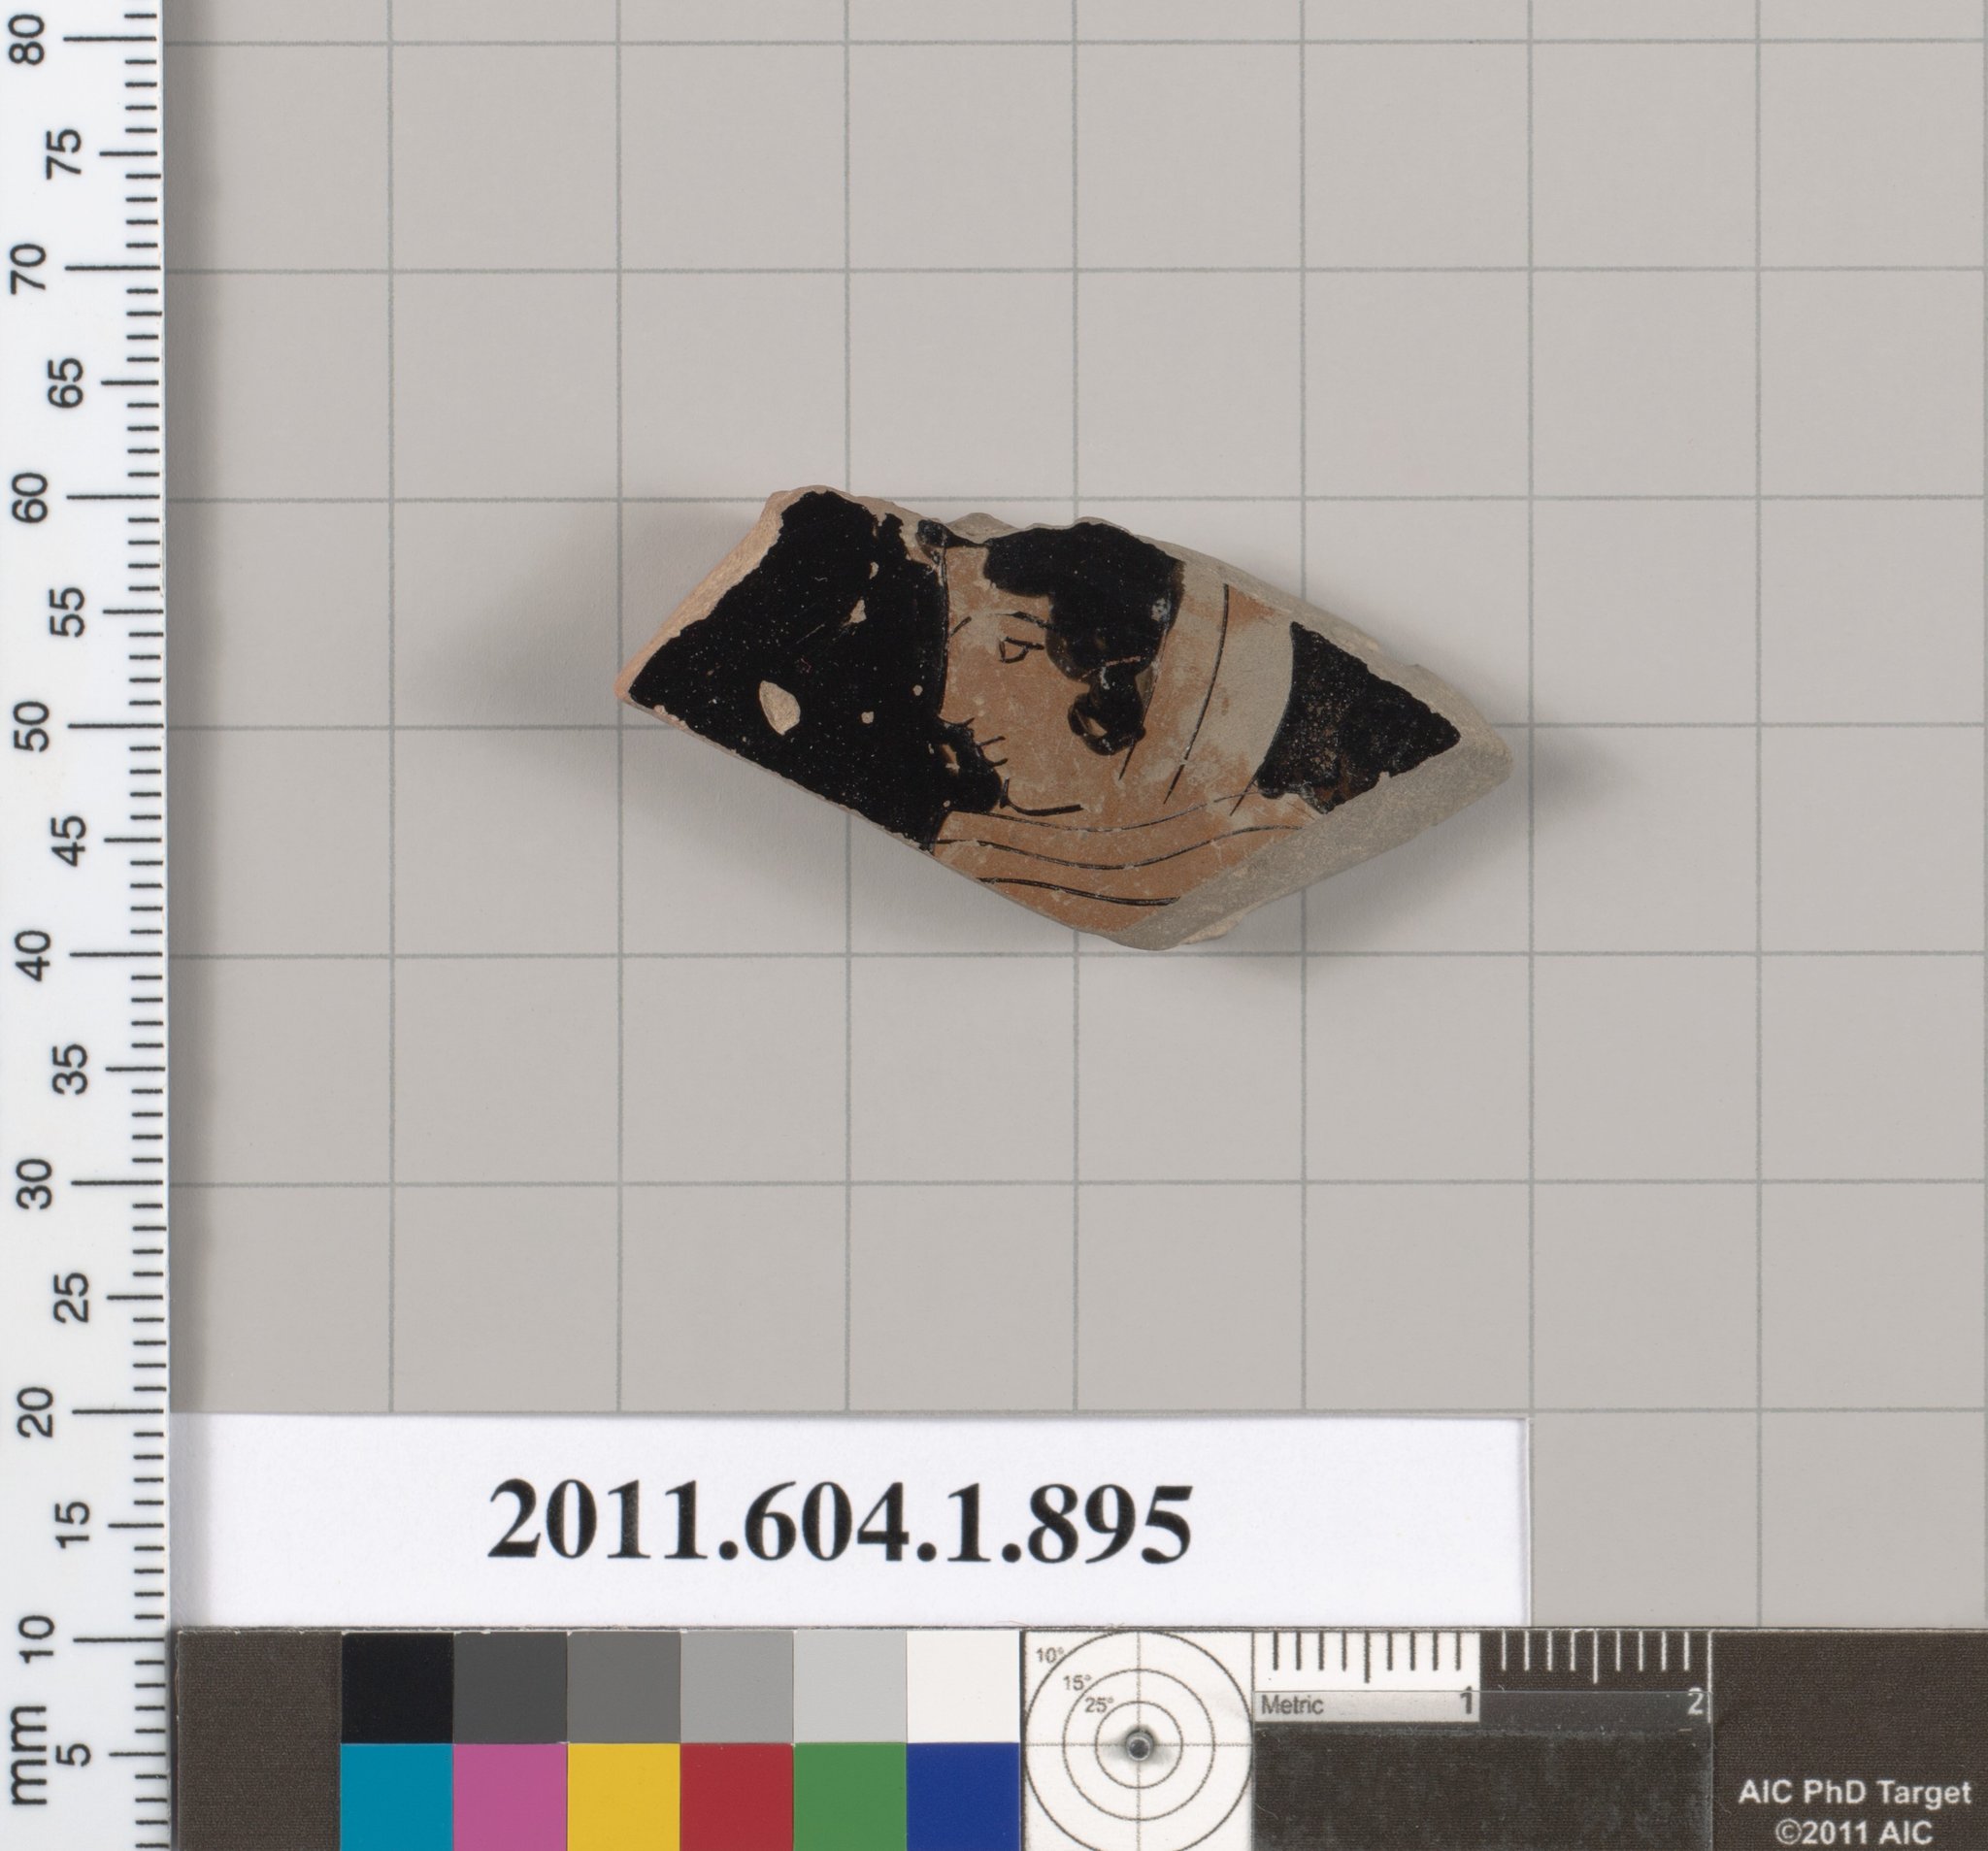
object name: kylix fragment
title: Terracotta fragment of a kylix (drinking cup)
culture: greek, attic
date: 467-435 BCE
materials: terracotta